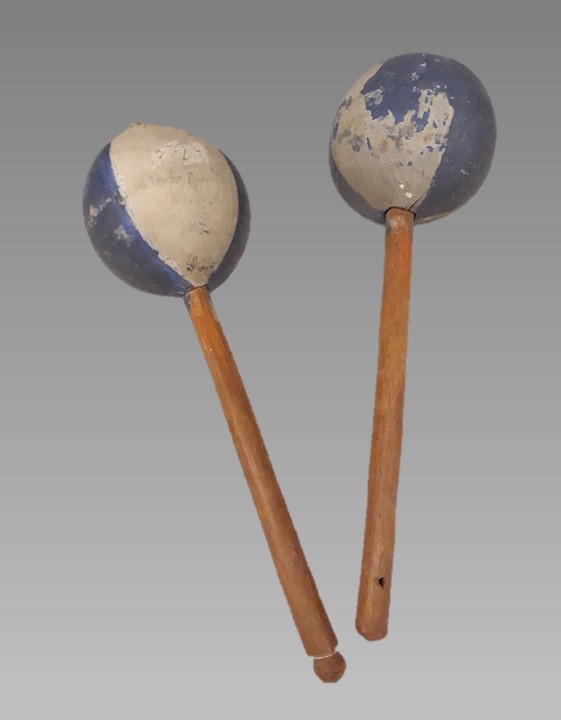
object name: maraca rattle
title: Maracas (rattles)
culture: cuban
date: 1867-1900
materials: metal, wood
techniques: polychrome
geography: cuba